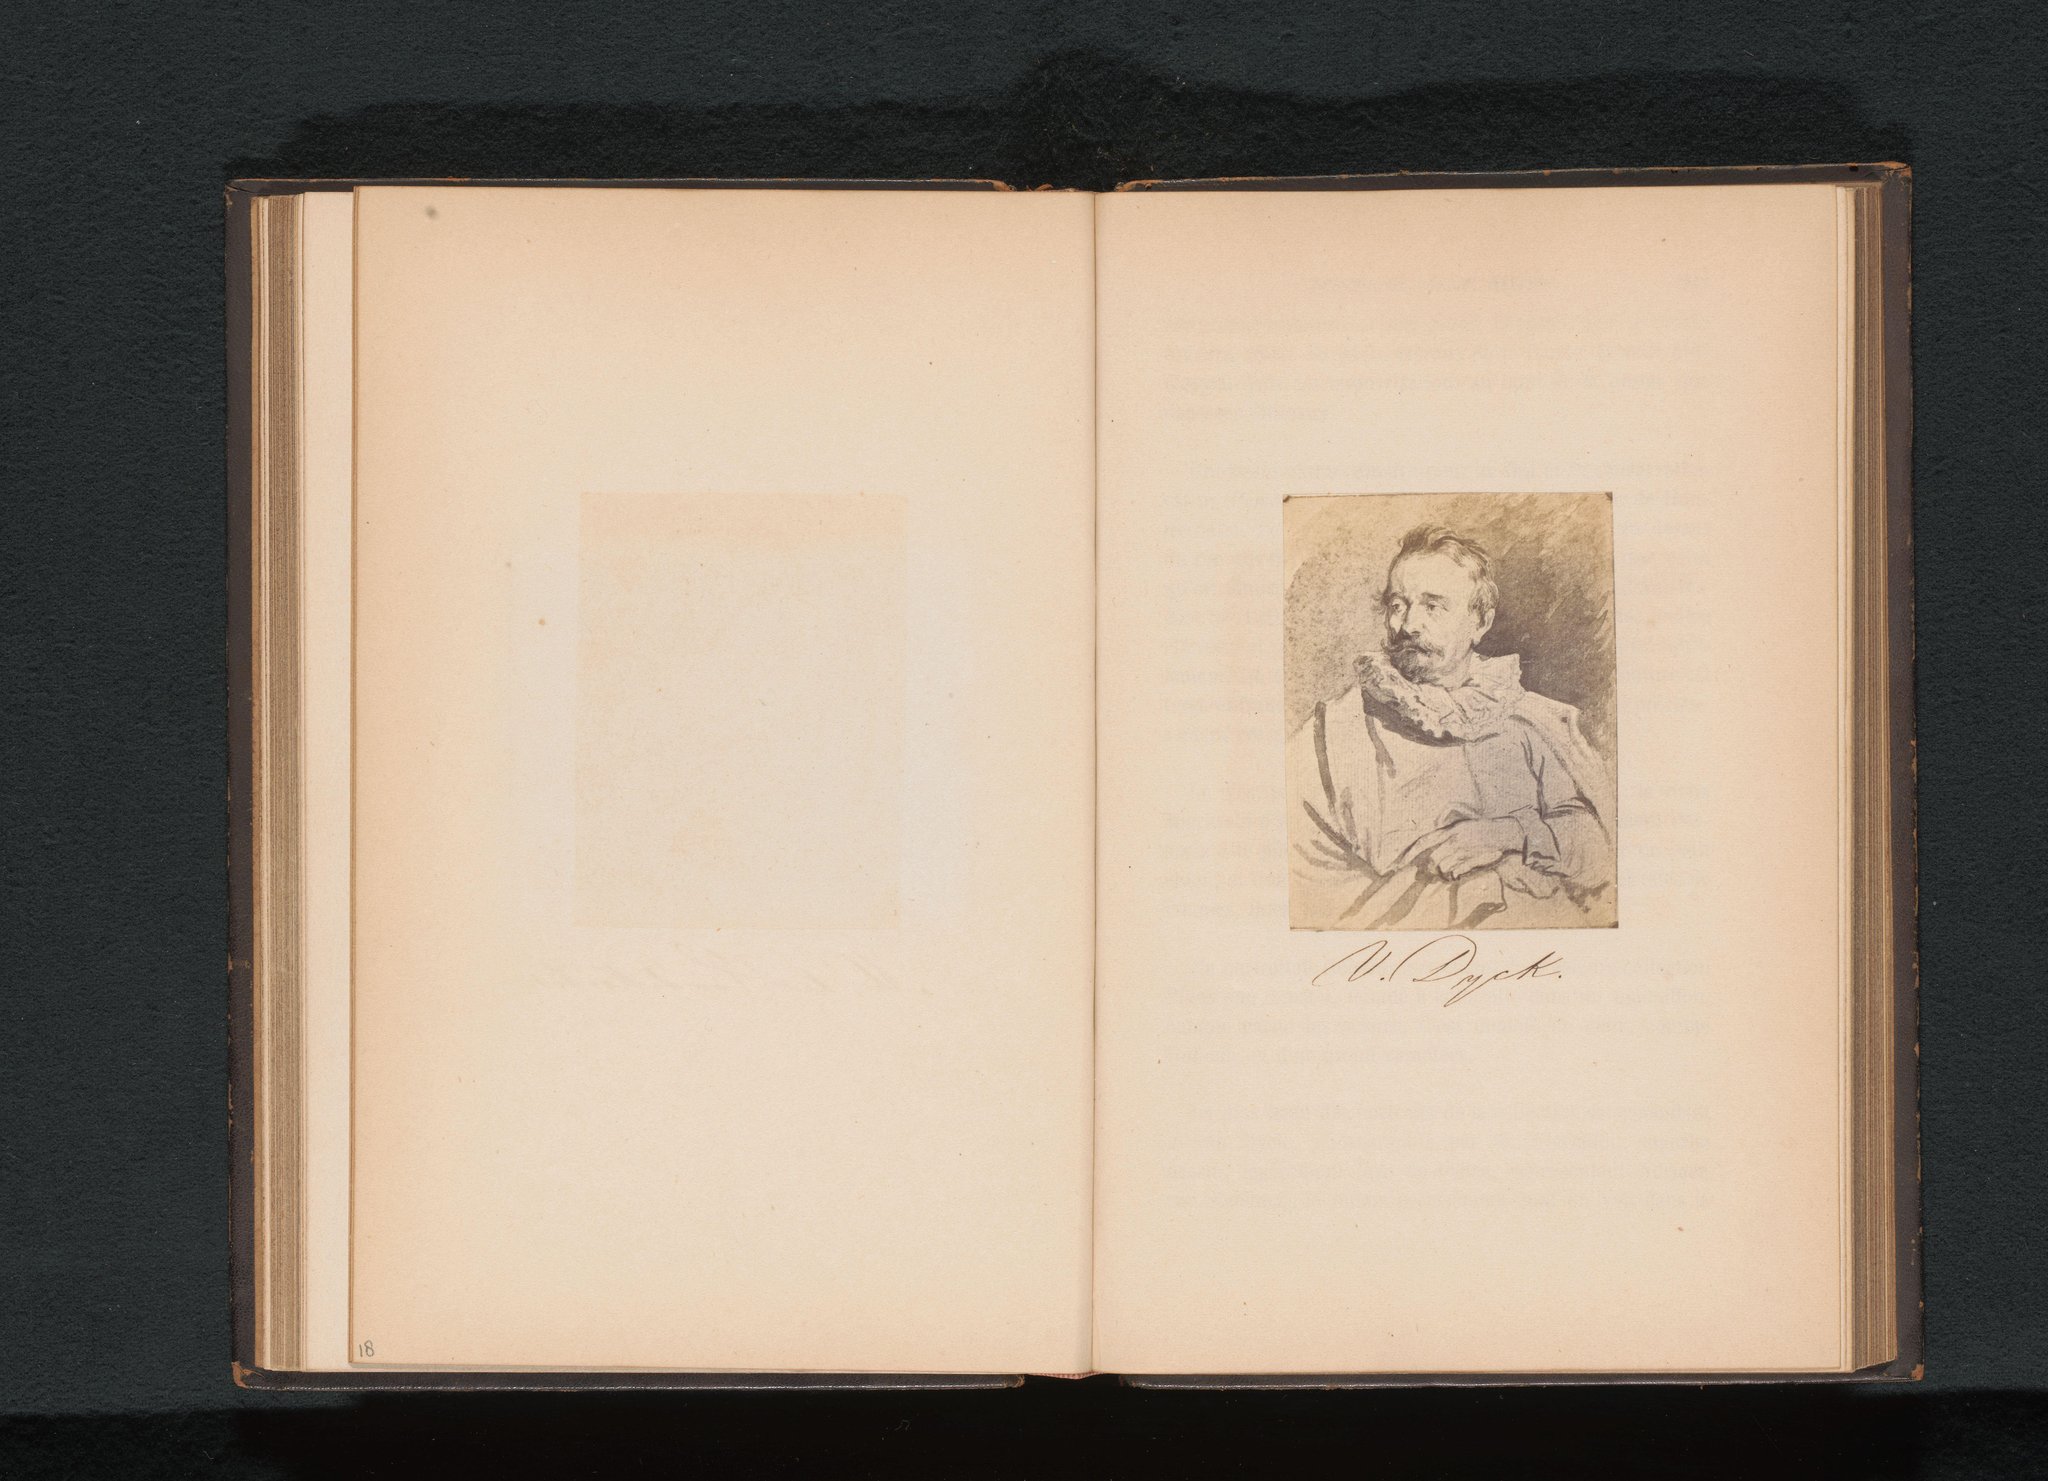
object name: page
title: Fotoreproductie van een getekend portret van Adrian van Stalbemt door Anthony van Dyck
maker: edmond fierlants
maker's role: fotograaf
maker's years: 1819-1869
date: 1855-1860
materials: photographic support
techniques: albumen print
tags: antwerp, painter, adriaen van stalbemt, historical persons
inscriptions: name: ‘V. Dyck.’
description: Foto op elfde ongenummerde pagina na pagina 114.